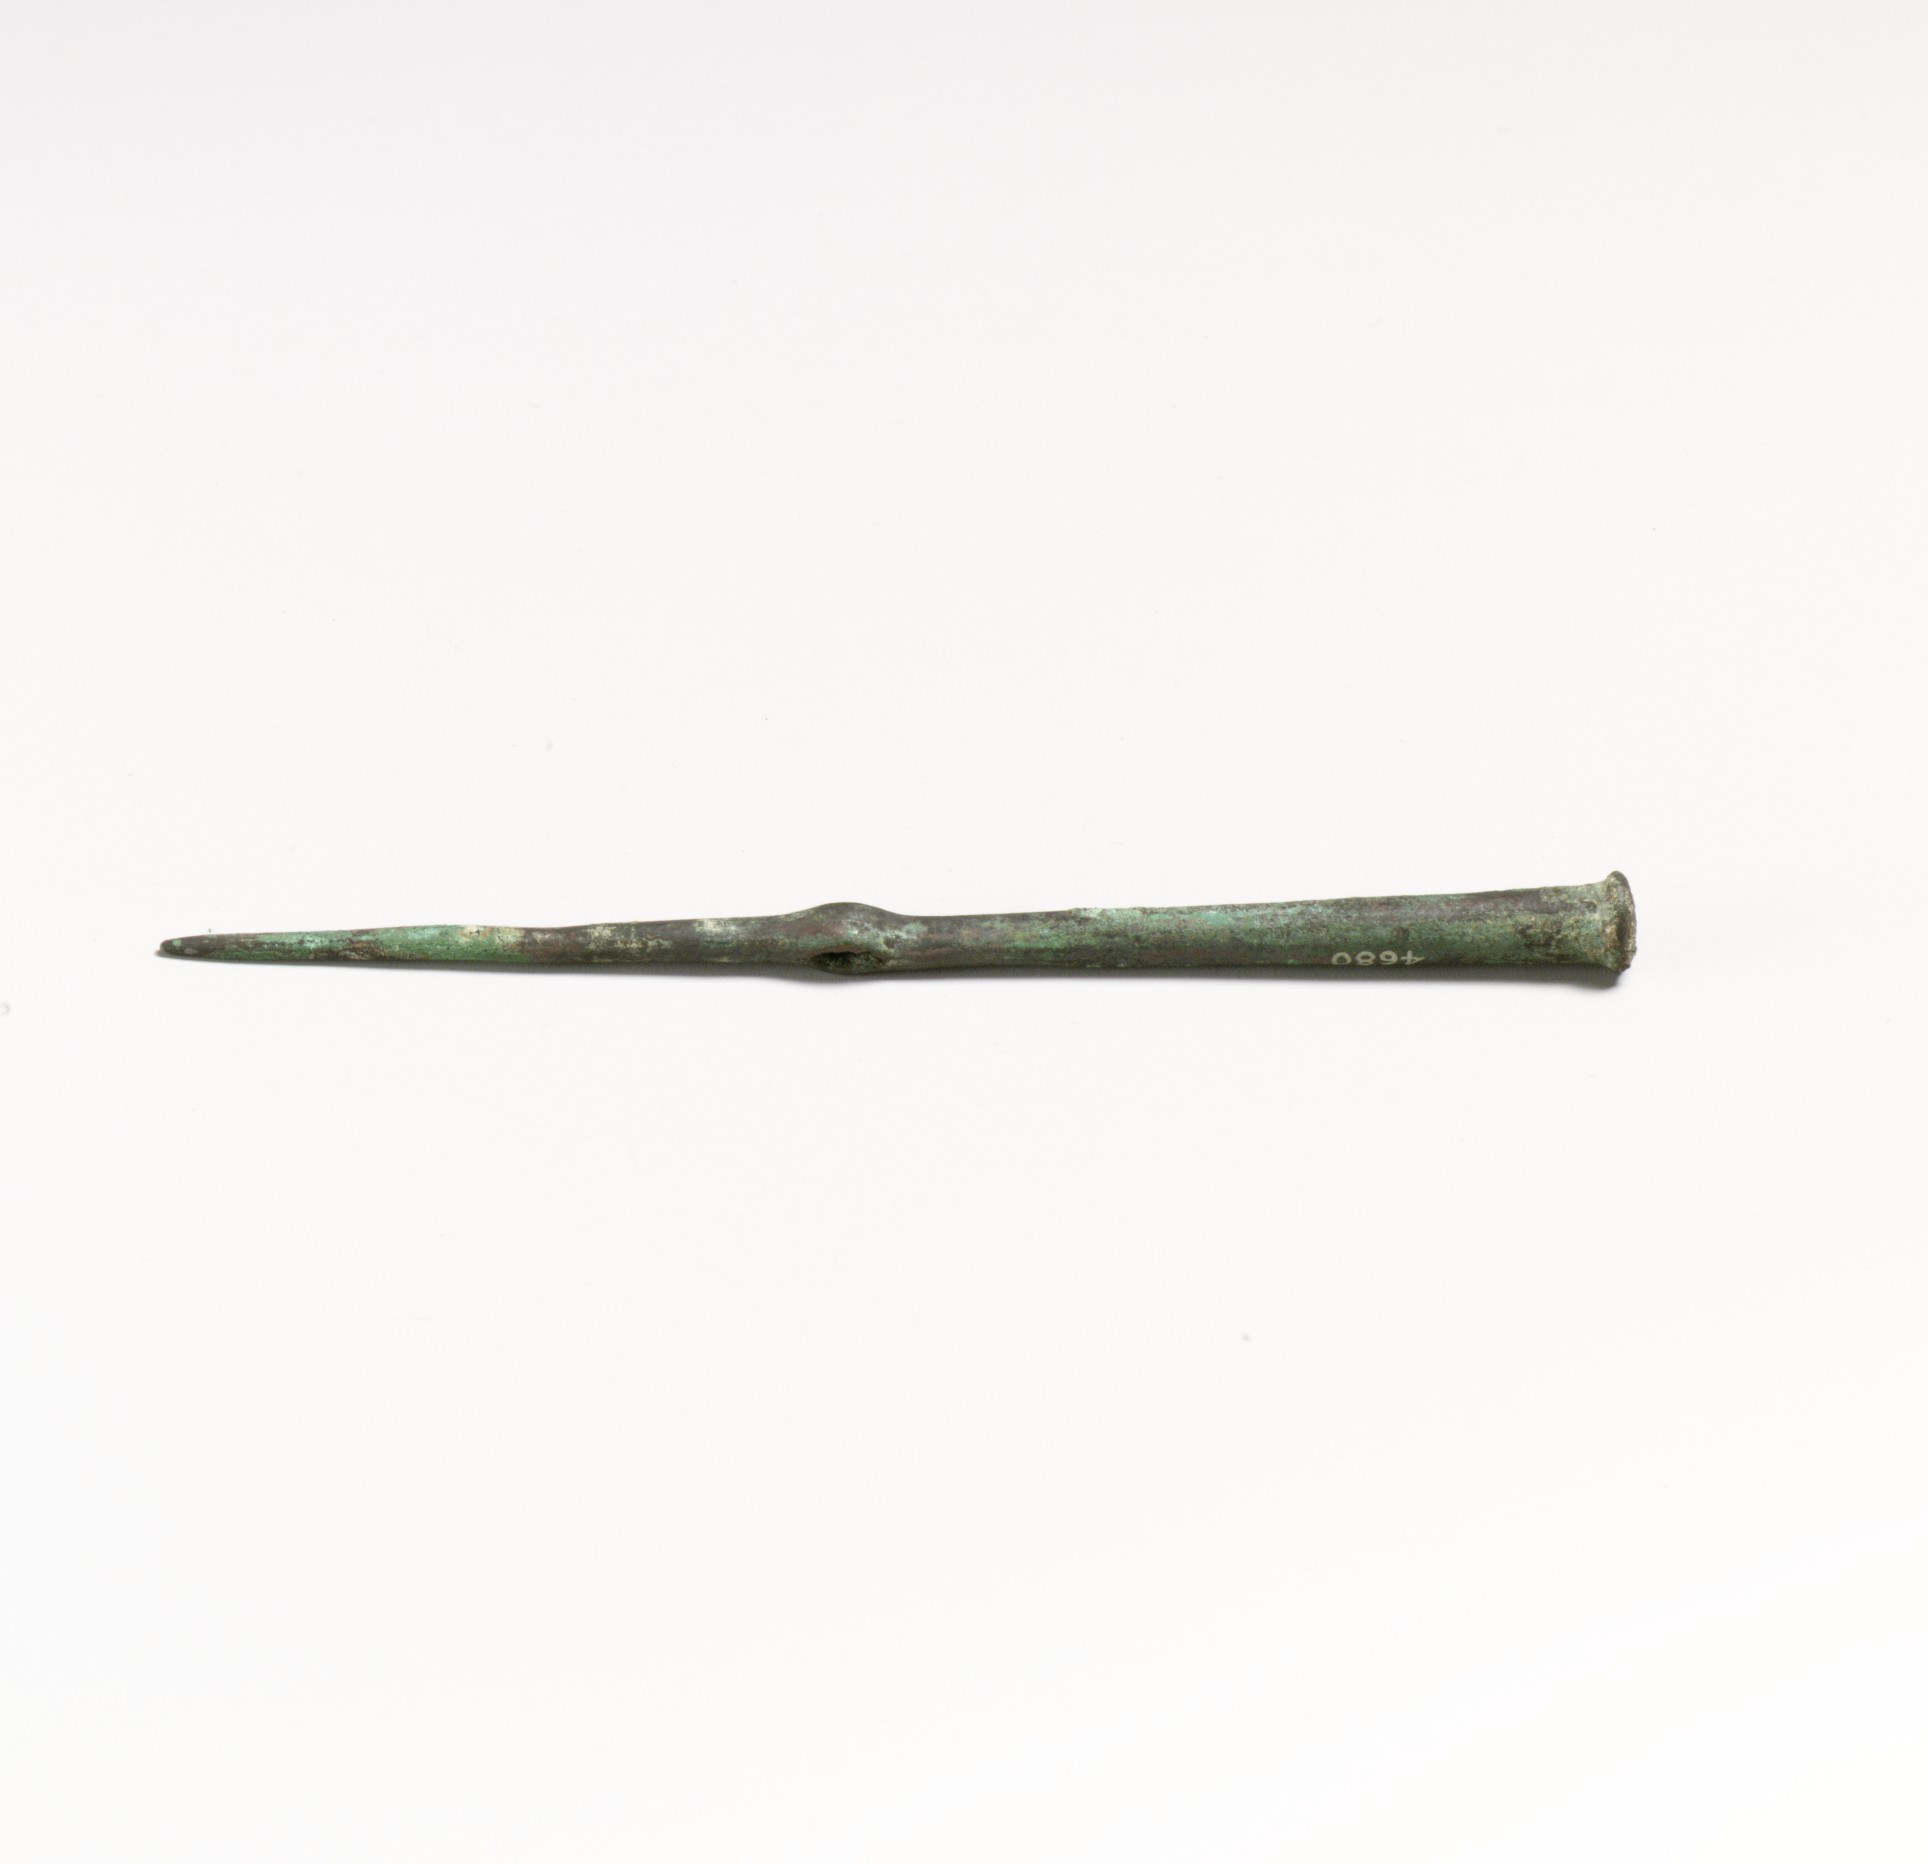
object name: pin, eyelet type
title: Bronze eyelet-type pin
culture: mycenaean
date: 1400-1301 BCE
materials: bronze